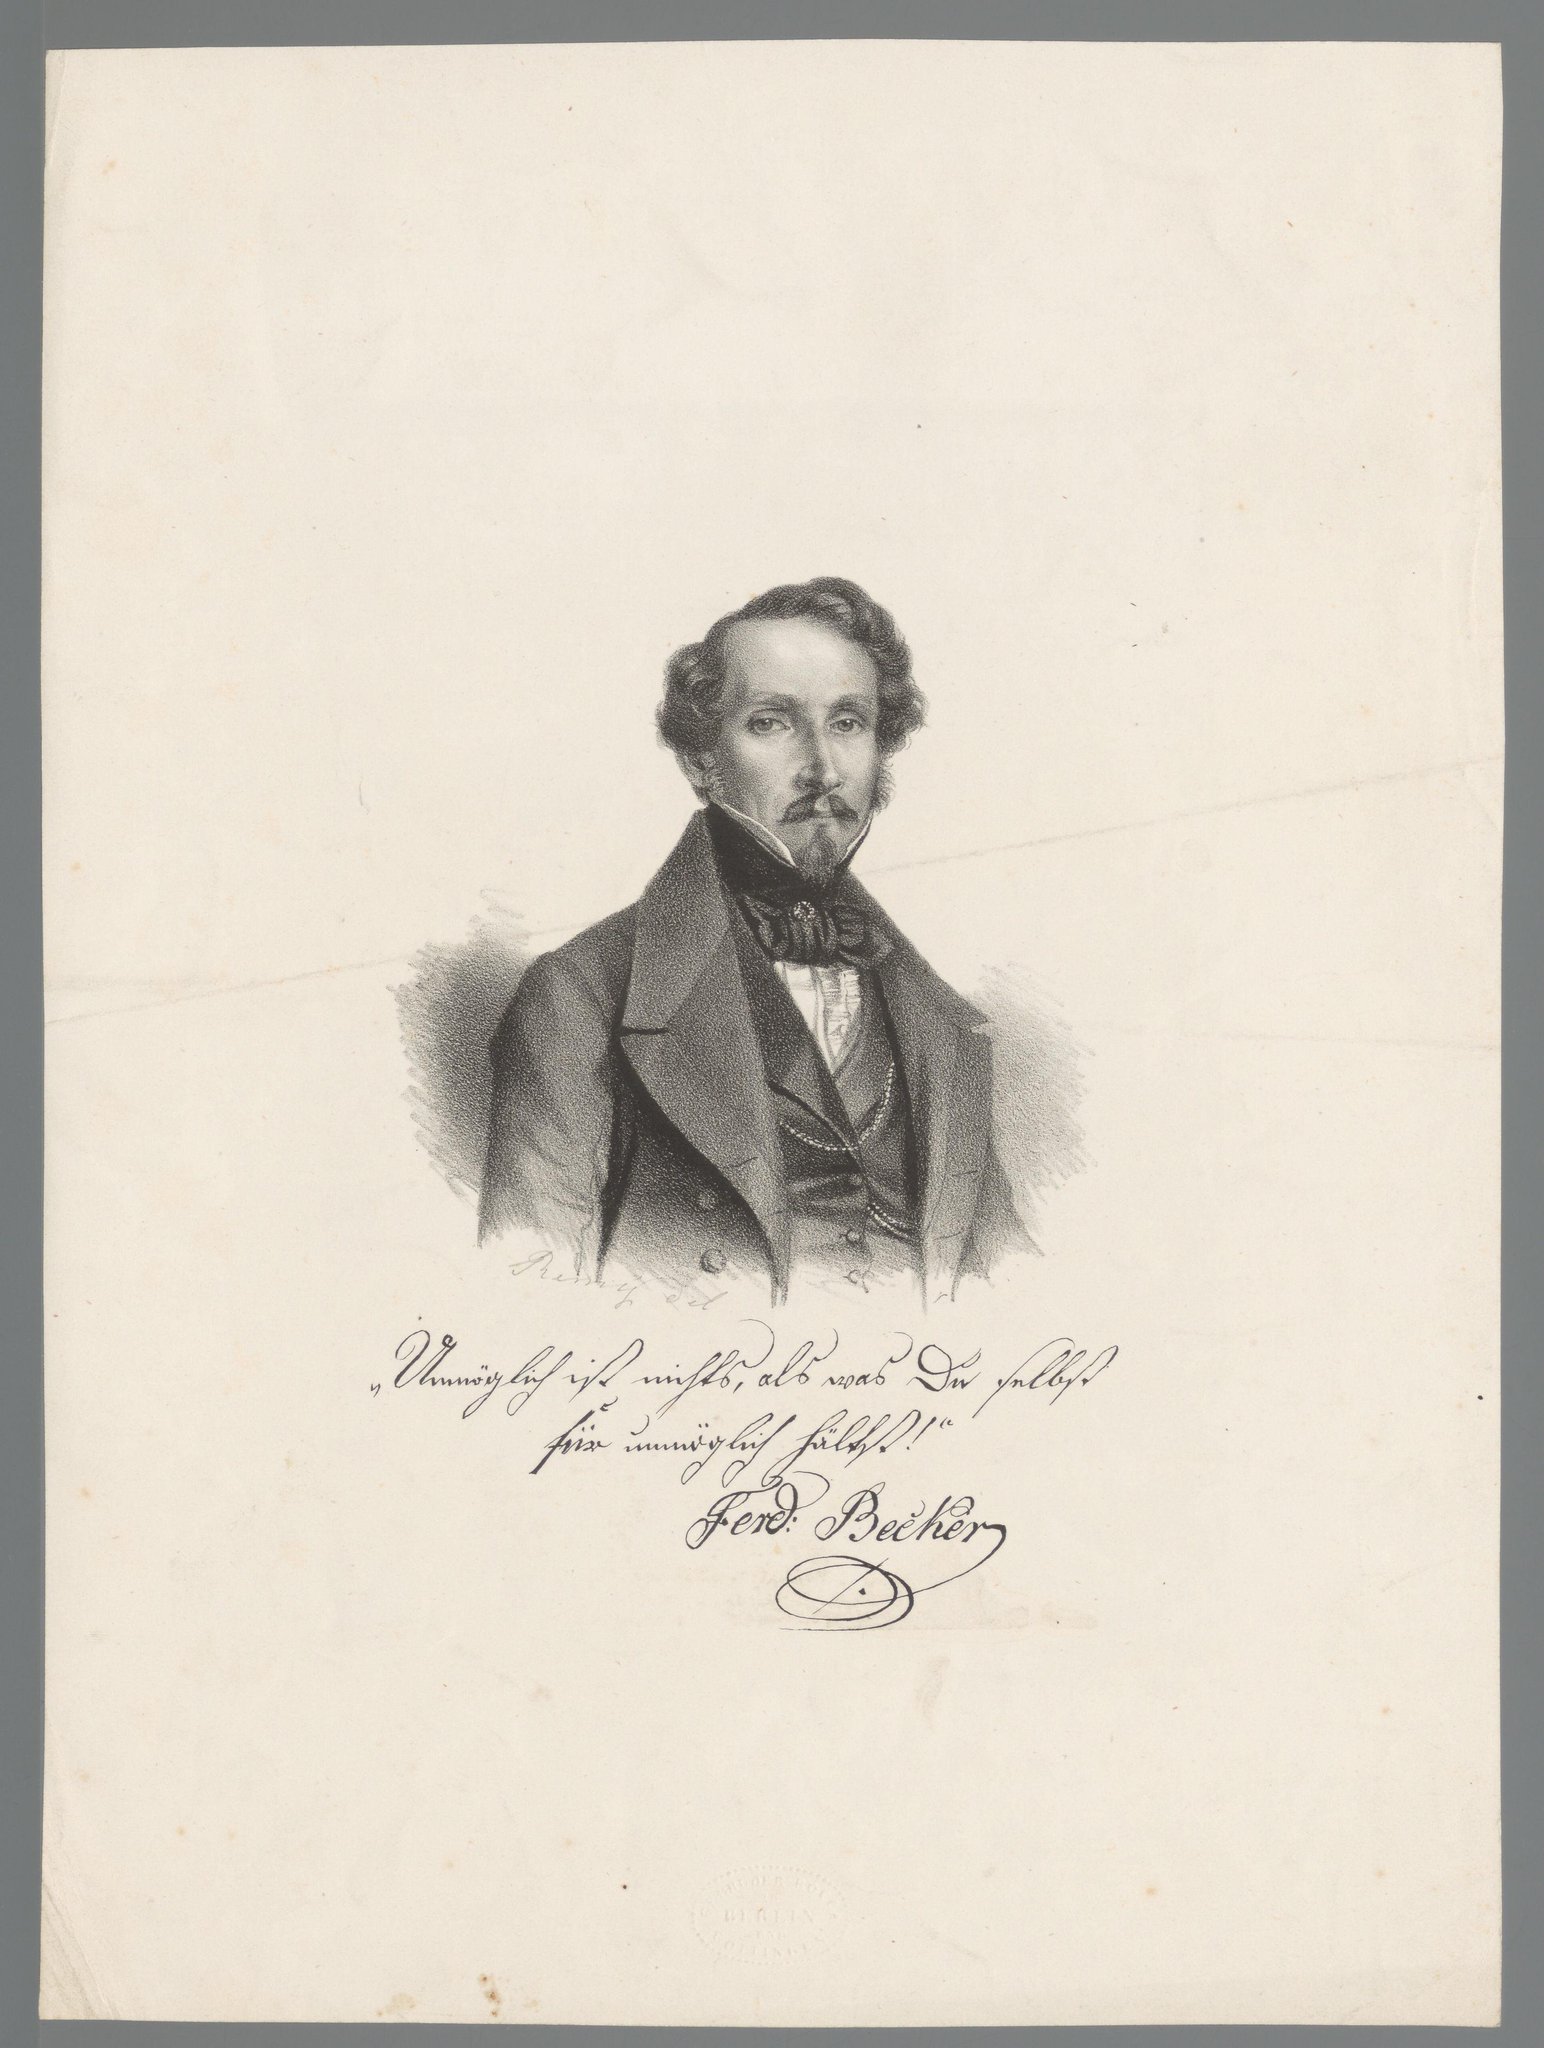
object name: print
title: Portret van Becker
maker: august remy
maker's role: print maker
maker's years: 1800-1872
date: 1810-1872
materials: paper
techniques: lithograph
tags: historical persons not known by name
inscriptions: check stamp: Lugt 5514, collector's mark: Lugt 2228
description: Portret van een verder onbekende man met de naam Ferd. Becker.